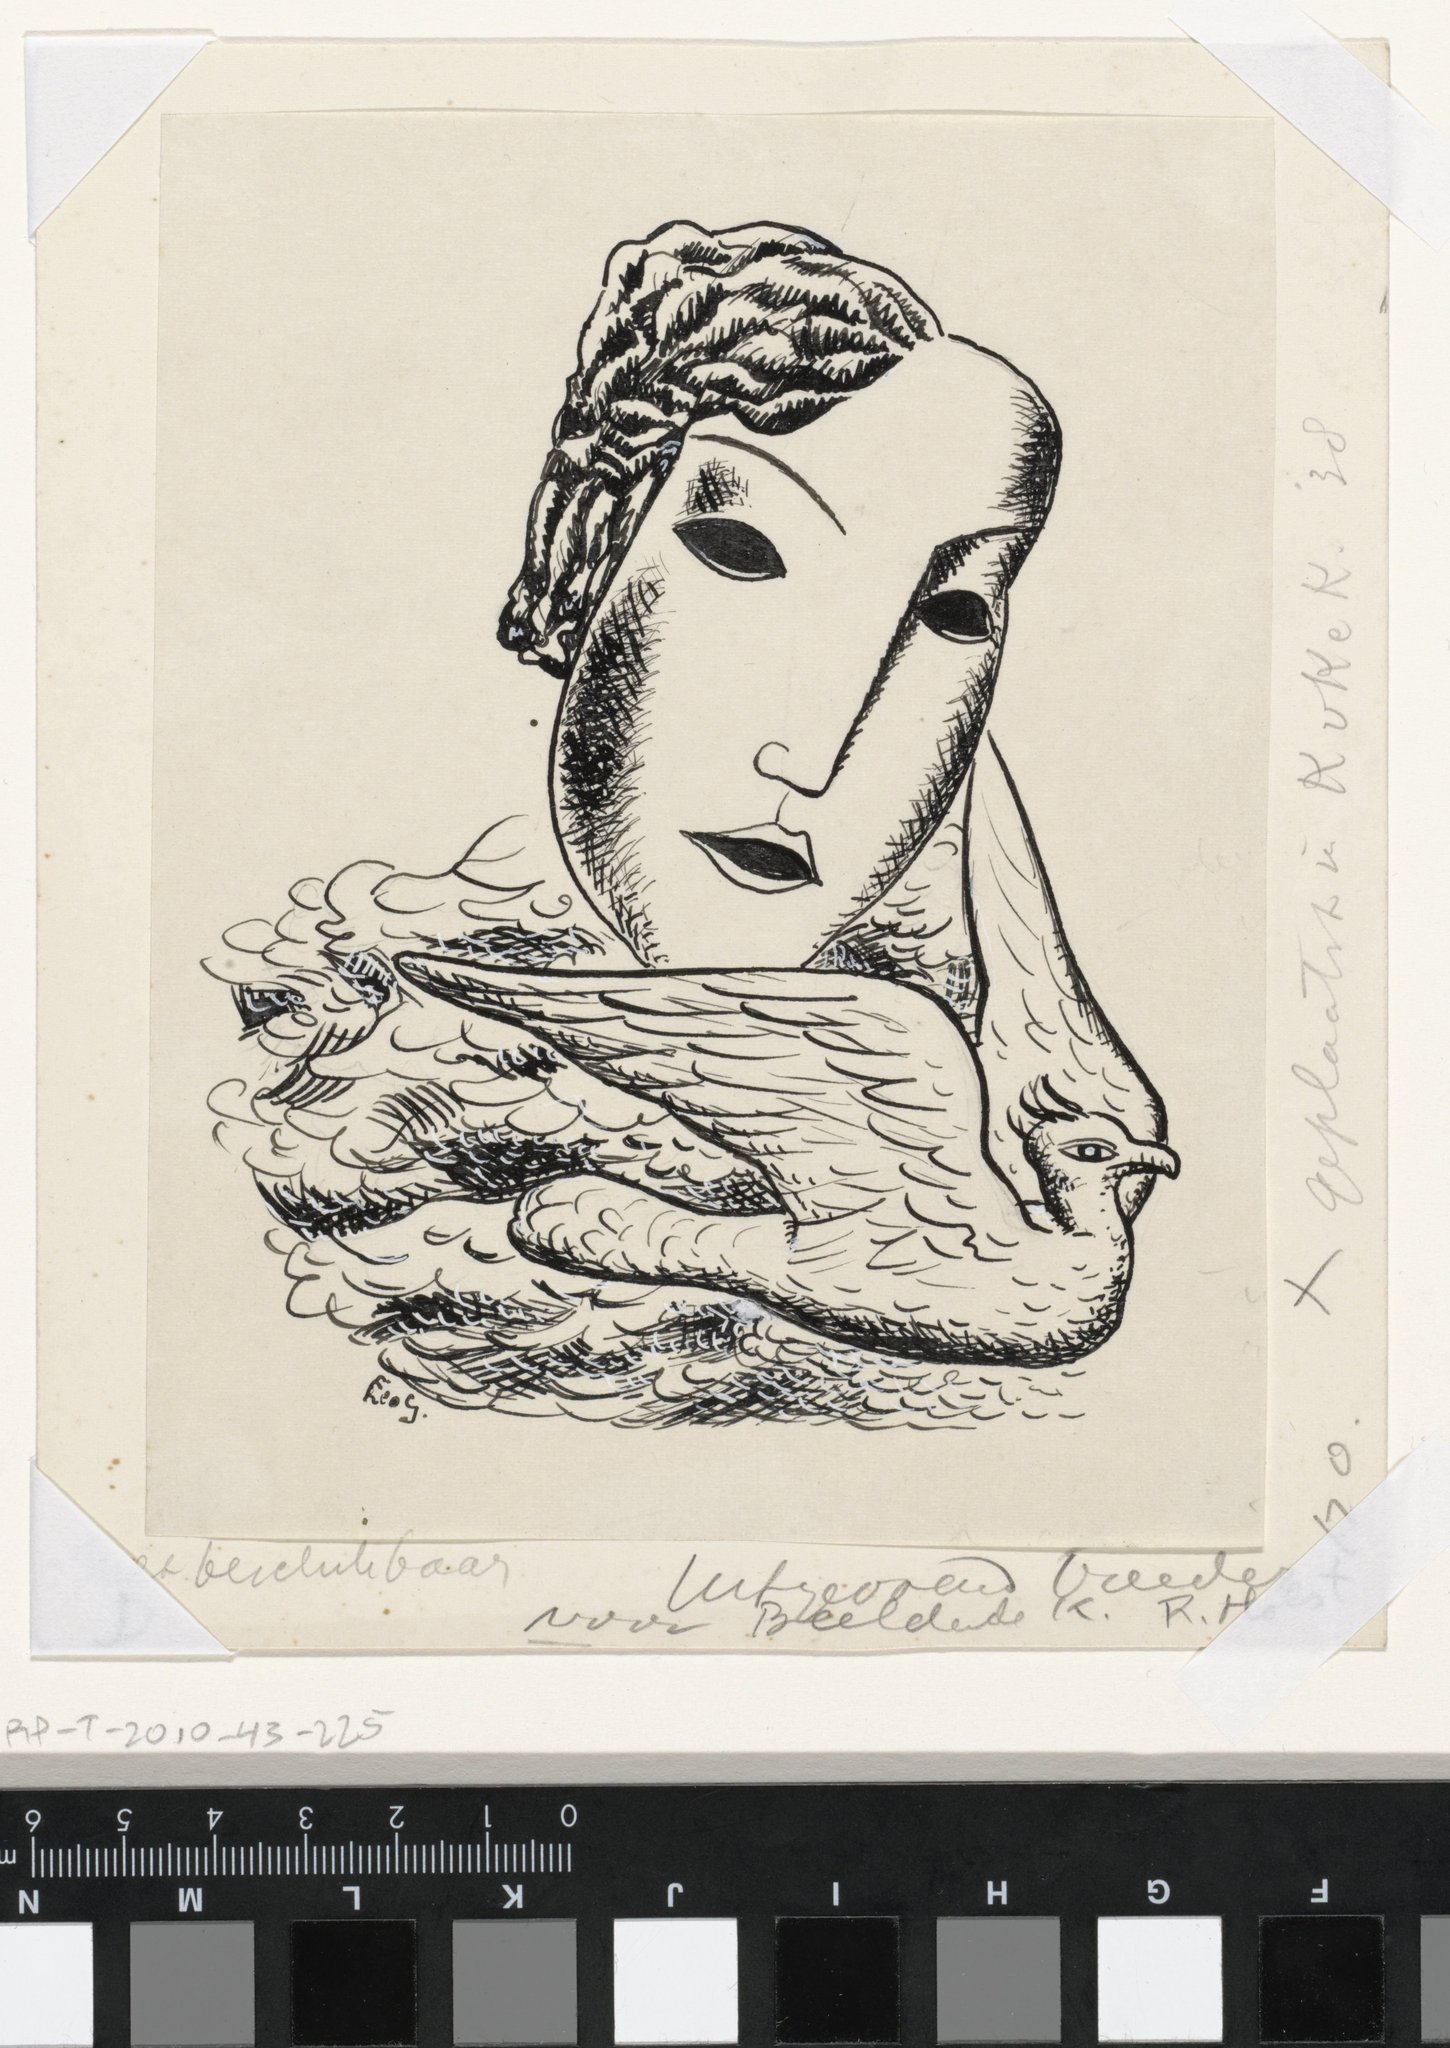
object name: drawing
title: Vrouwenkop met vogel (schets)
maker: leo gestel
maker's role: draughtsman, print maker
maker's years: 1881-1941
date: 1935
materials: gouache, ink, paper, pencil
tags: birds, head (human) - aa - female human figure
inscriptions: inscription: ‘x geplaatst in KvKeK. '38’, inscription: ‘voor Beeldende K. R. Holst’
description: Midden boven maskerachtige vrouwenkop, rechtsonder klapwiekende vogel boven zee.